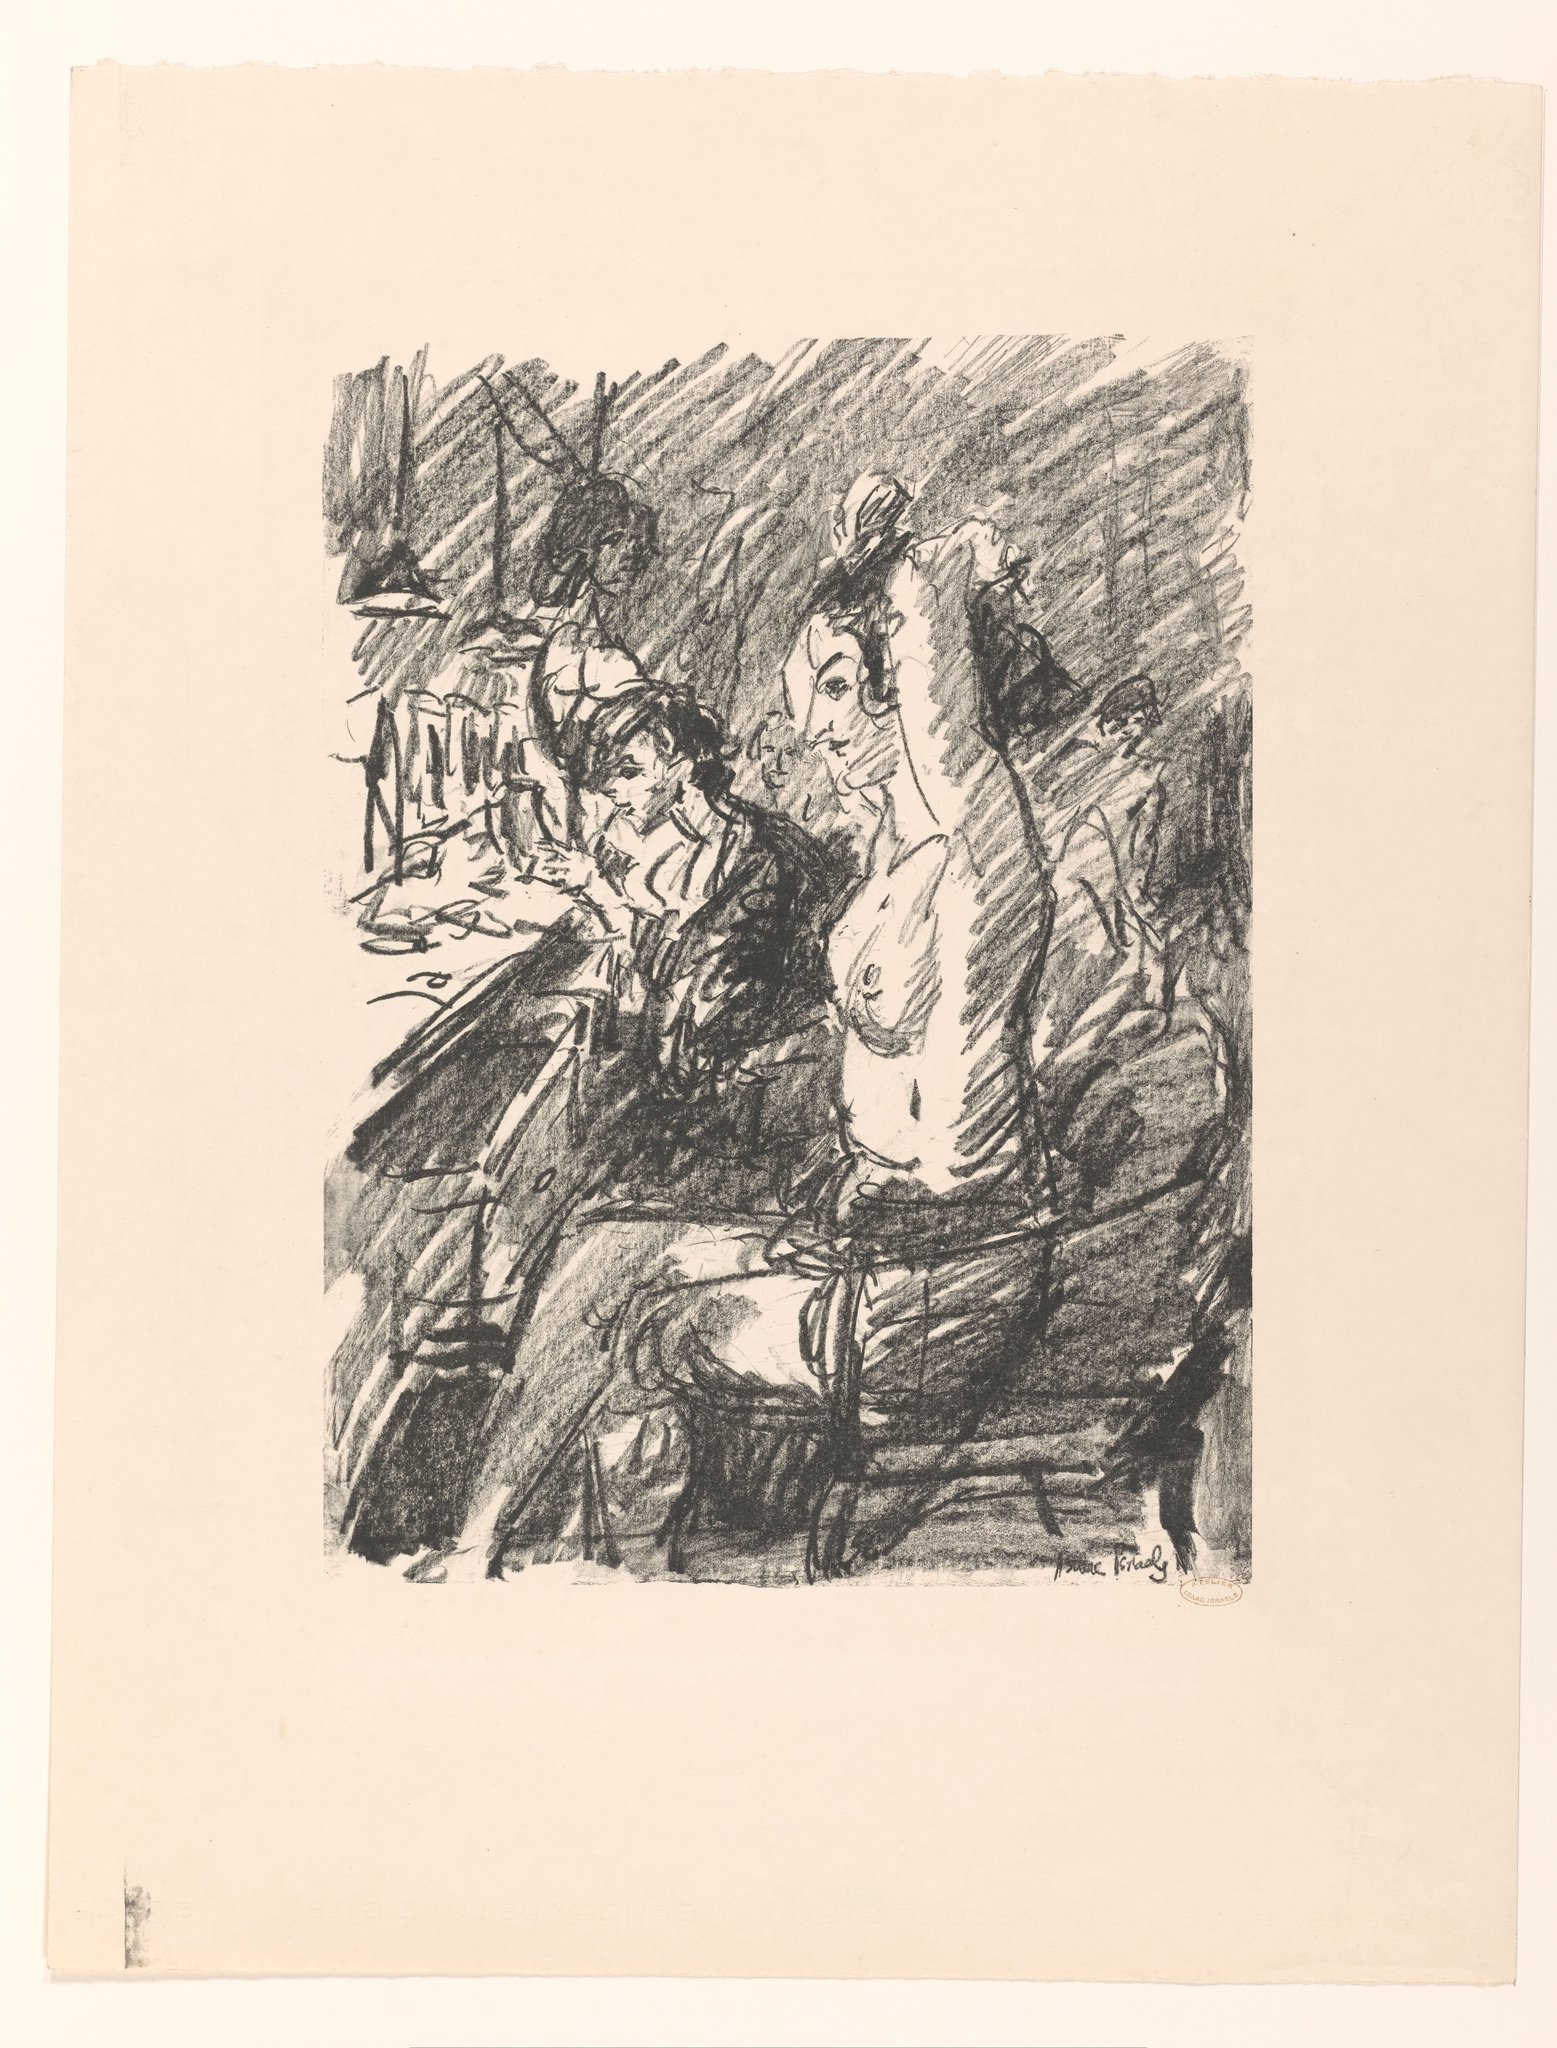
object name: print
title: Artiesten voor de spiegel in de kleedkamer van een theater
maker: isaac israels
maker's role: draughtsman, painter, print maker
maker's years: 1865-1934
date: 1875-1934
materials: paper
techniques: lithograph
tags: theatre, theatrical performance, mirror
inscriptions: collector's mark: Lugt 2228, collector's mark: Lugt 1402a